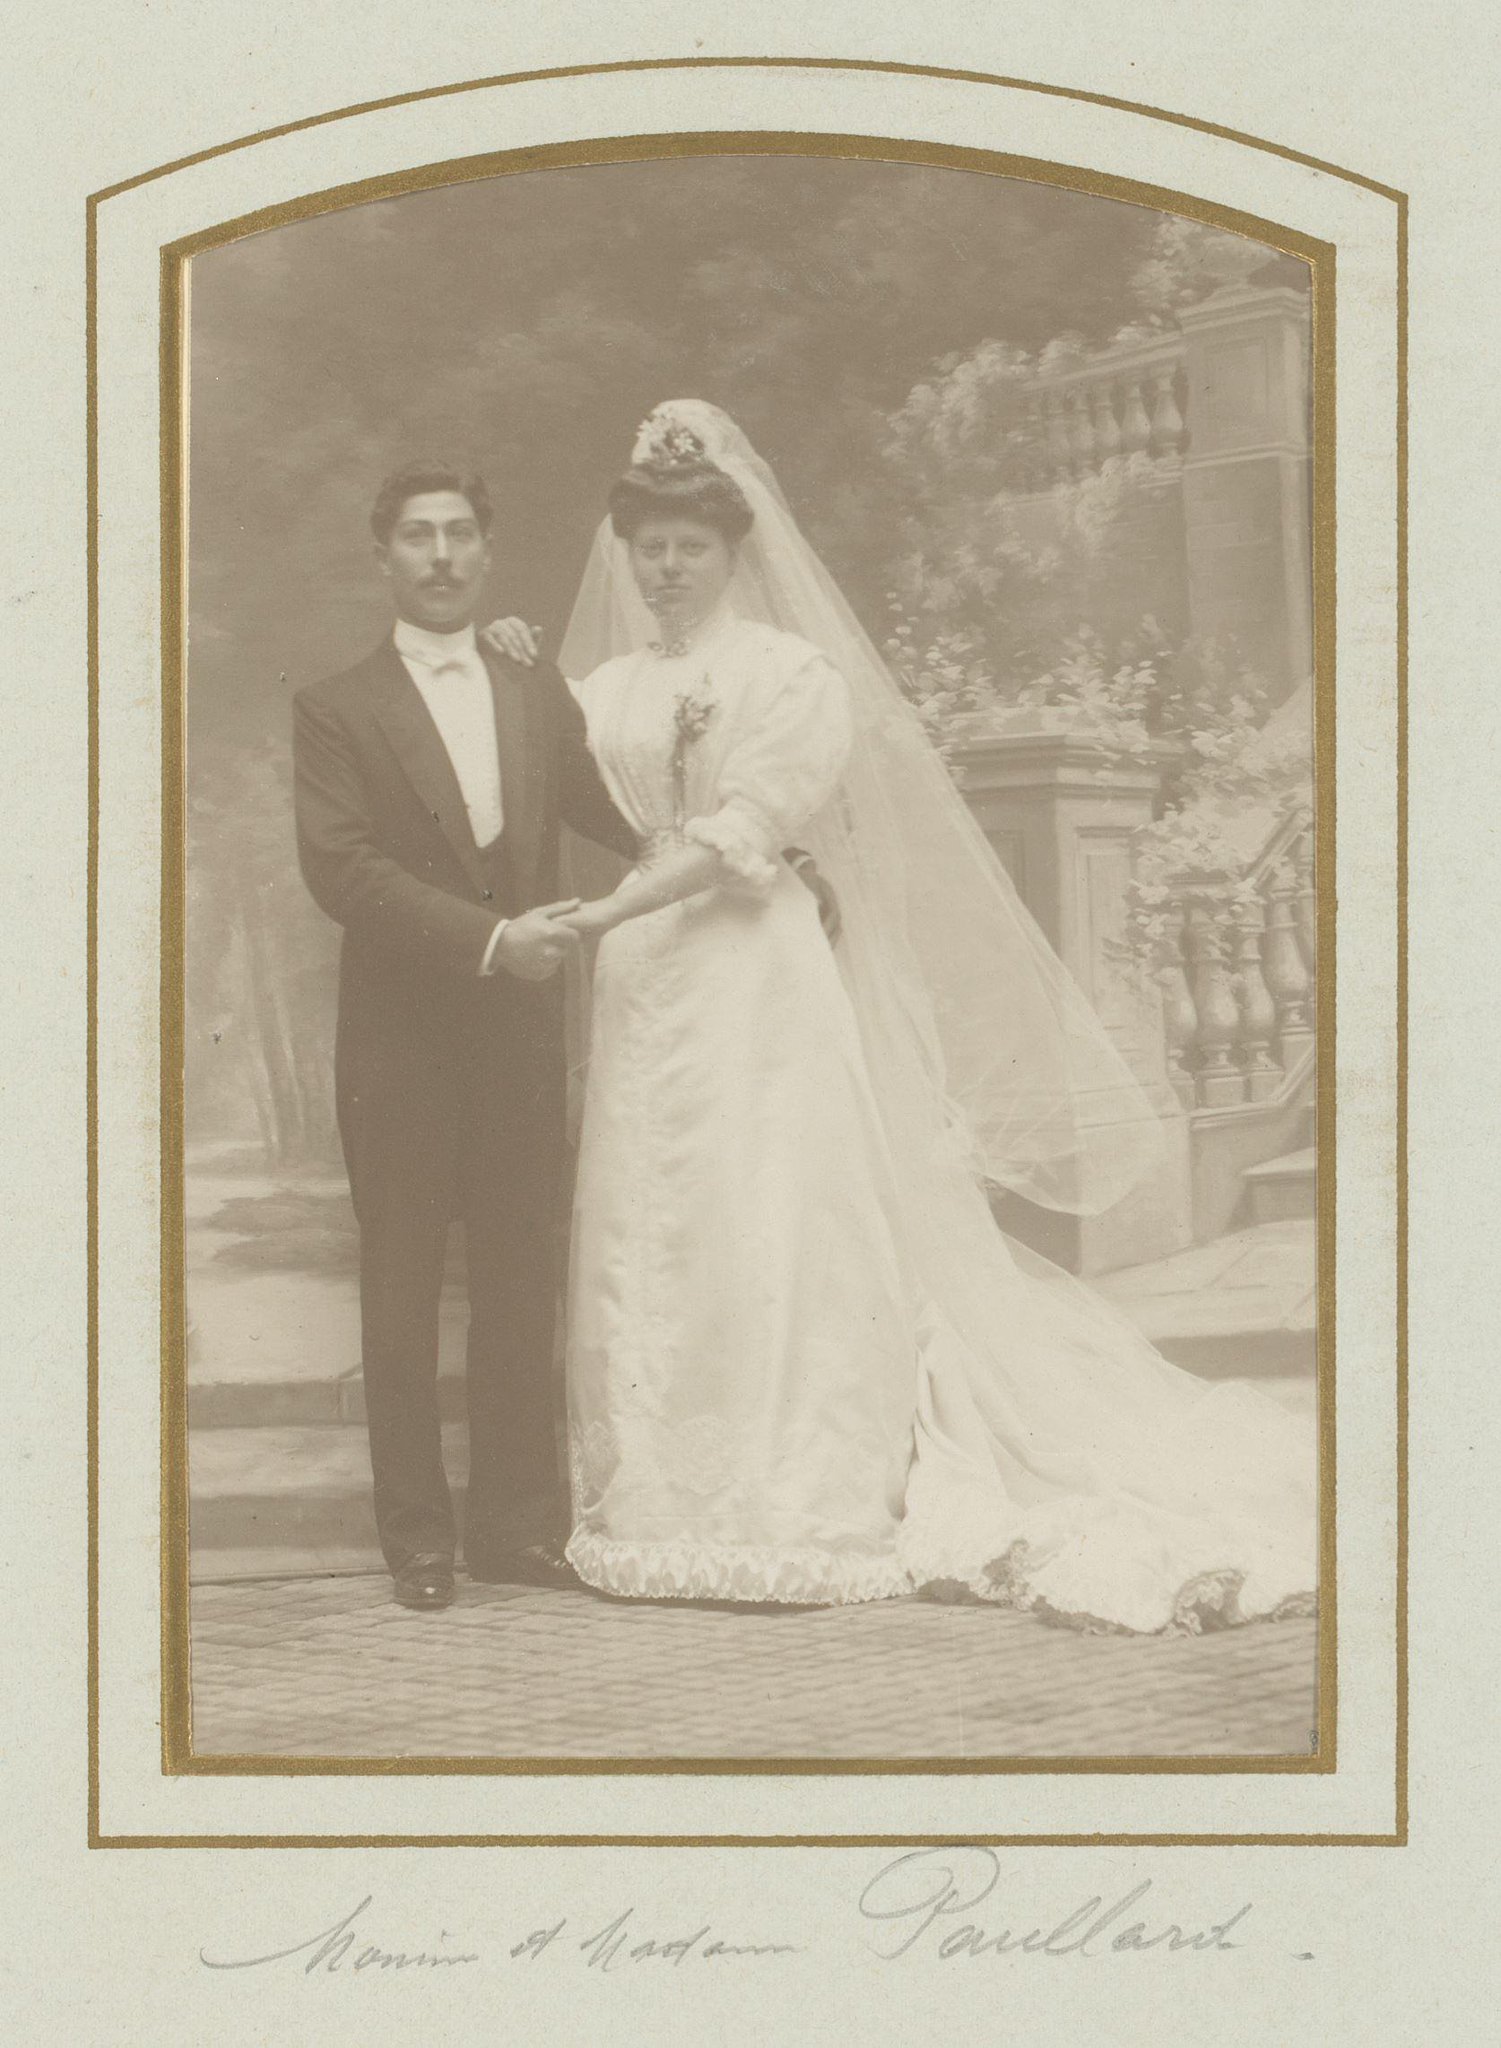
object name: album leaf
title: Portret van een bruidspaar, aangeduid als het echtpaar Paullart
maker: morand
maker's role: fotograaf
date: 1895-1920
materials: cardboard, photographic support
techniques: matte daylight collodion silver print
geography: suresnes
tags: historical persons - bb - woman, historical persons, bride and groom in wedding-dress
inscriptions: inscription: ‘Photographie/ Artistique/ & Industrielle/ Téléphone/ No 46/ Maison Privée/ MORAND/ 12/ Bould. de Versailles/ Suresnes/ Agrandissements & Reproductions/ EN TOUS GENRES/ PHOTOGRAPHIE a DOMICILE’, name: ‘Monsieur et Madame Paullart.’